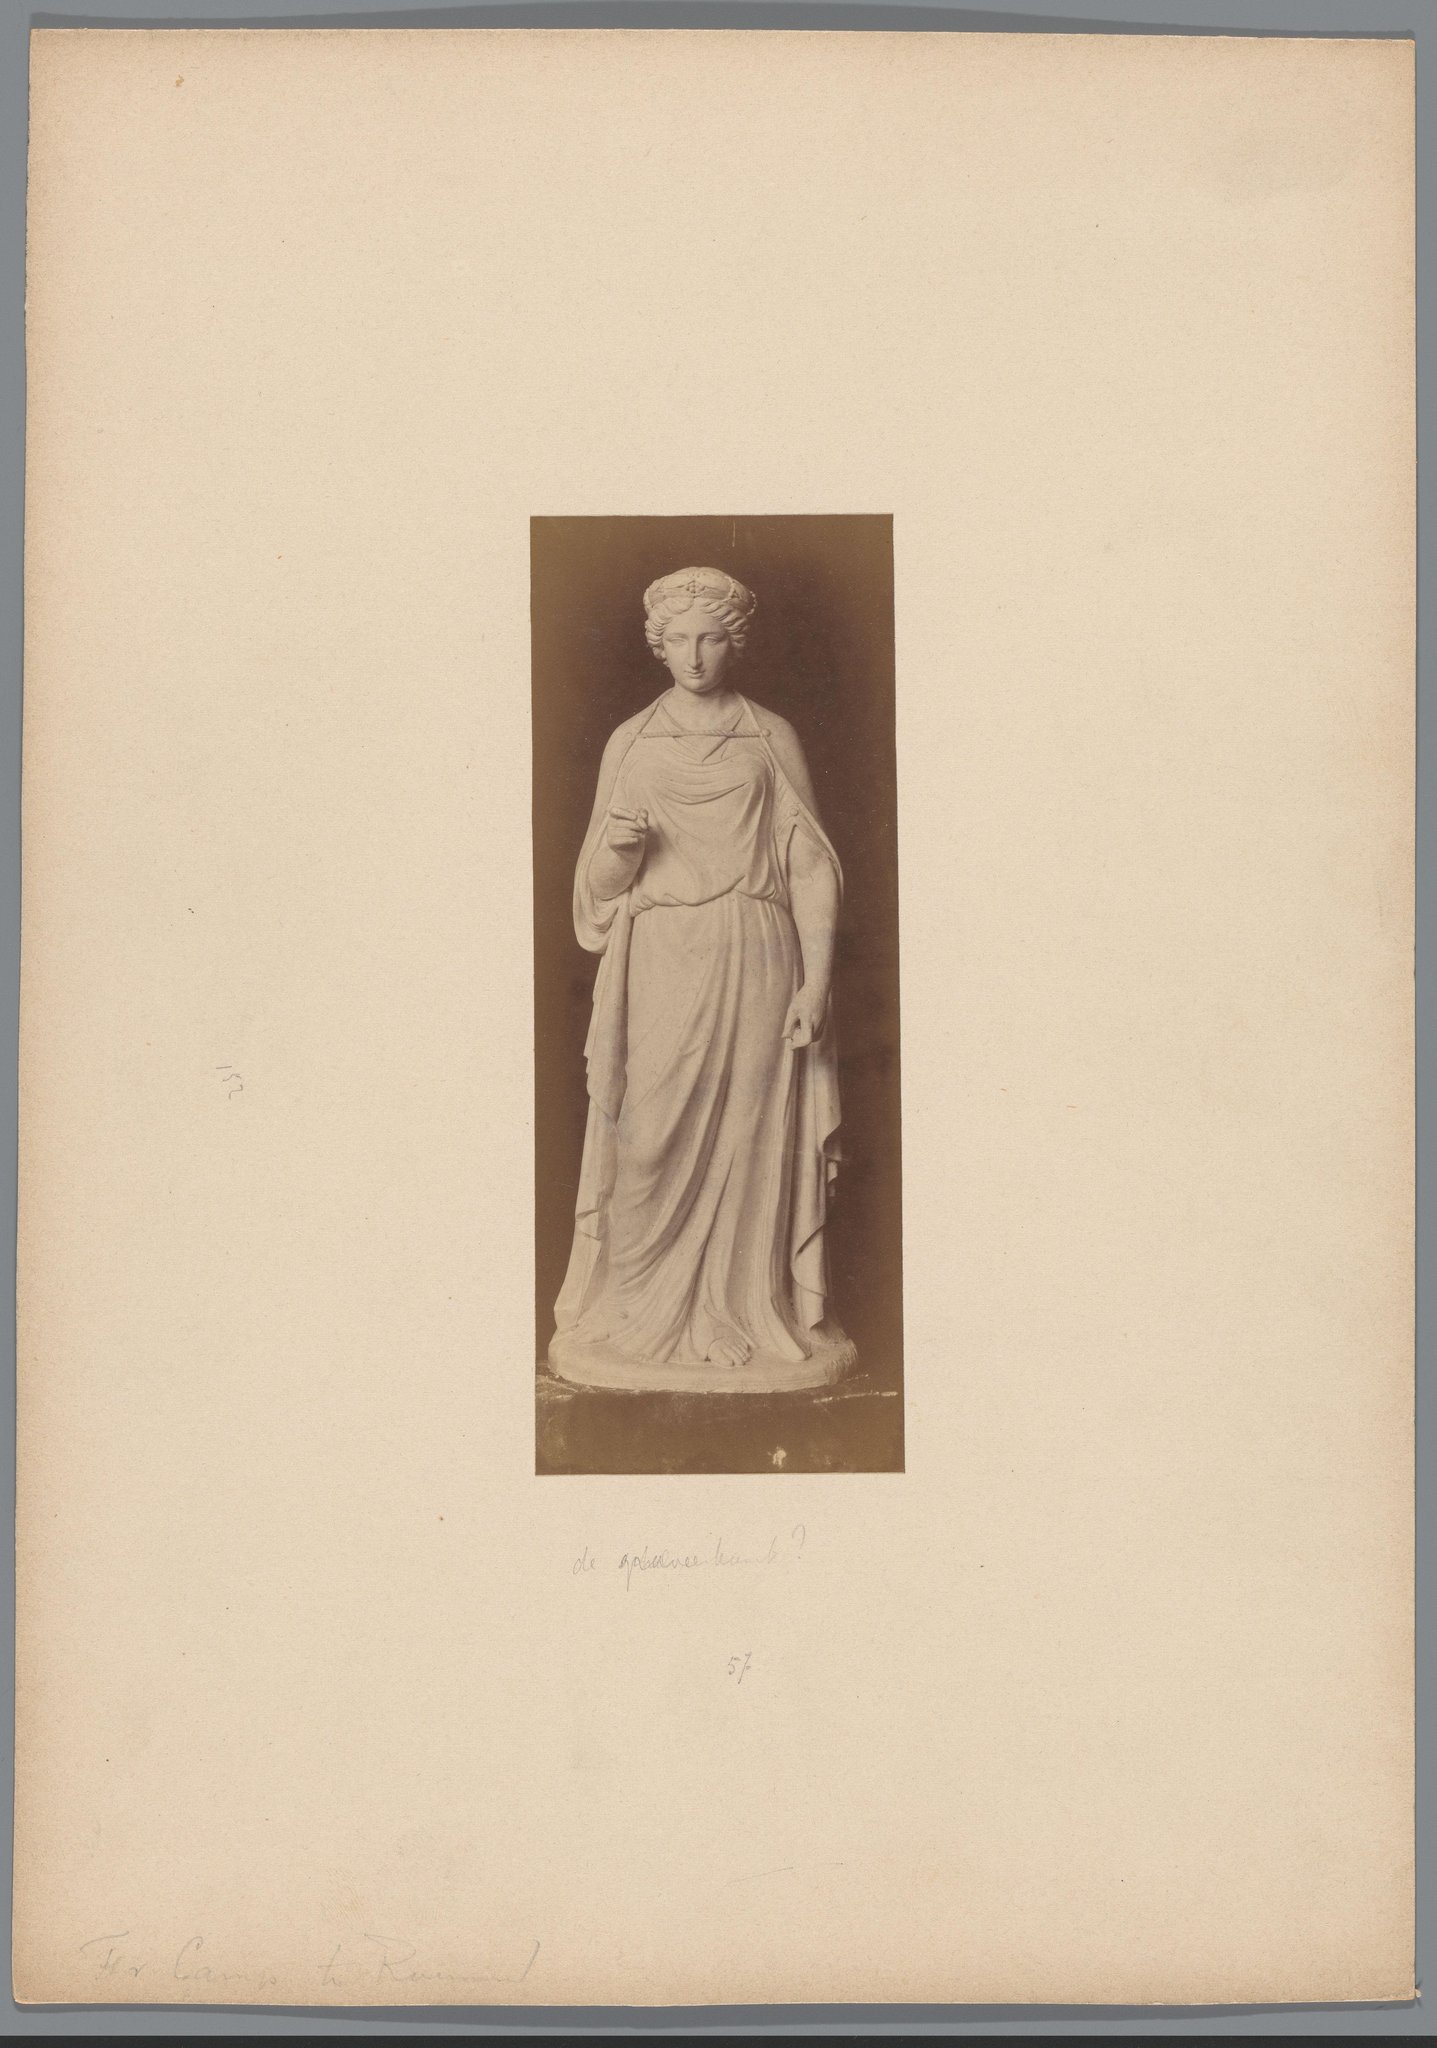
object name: reproduction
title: Modellen van beeldhouwwerken voor een prijsvraag uitgeschreven door het Rijksmuseum Amsterdam, 1880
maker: Anonymous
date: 1880-1887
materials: cardboard, paper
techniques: albumen print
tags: symbolic representations, allegories and emblems ~ the graphic arts, piece of sculpture, reproduction of a piece of sculpture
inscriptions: inscription: ‘Fr. Camp te Roermond’, collector's mark: Lugt 2228, inscription: ‘de graveerkunst?/ 57’